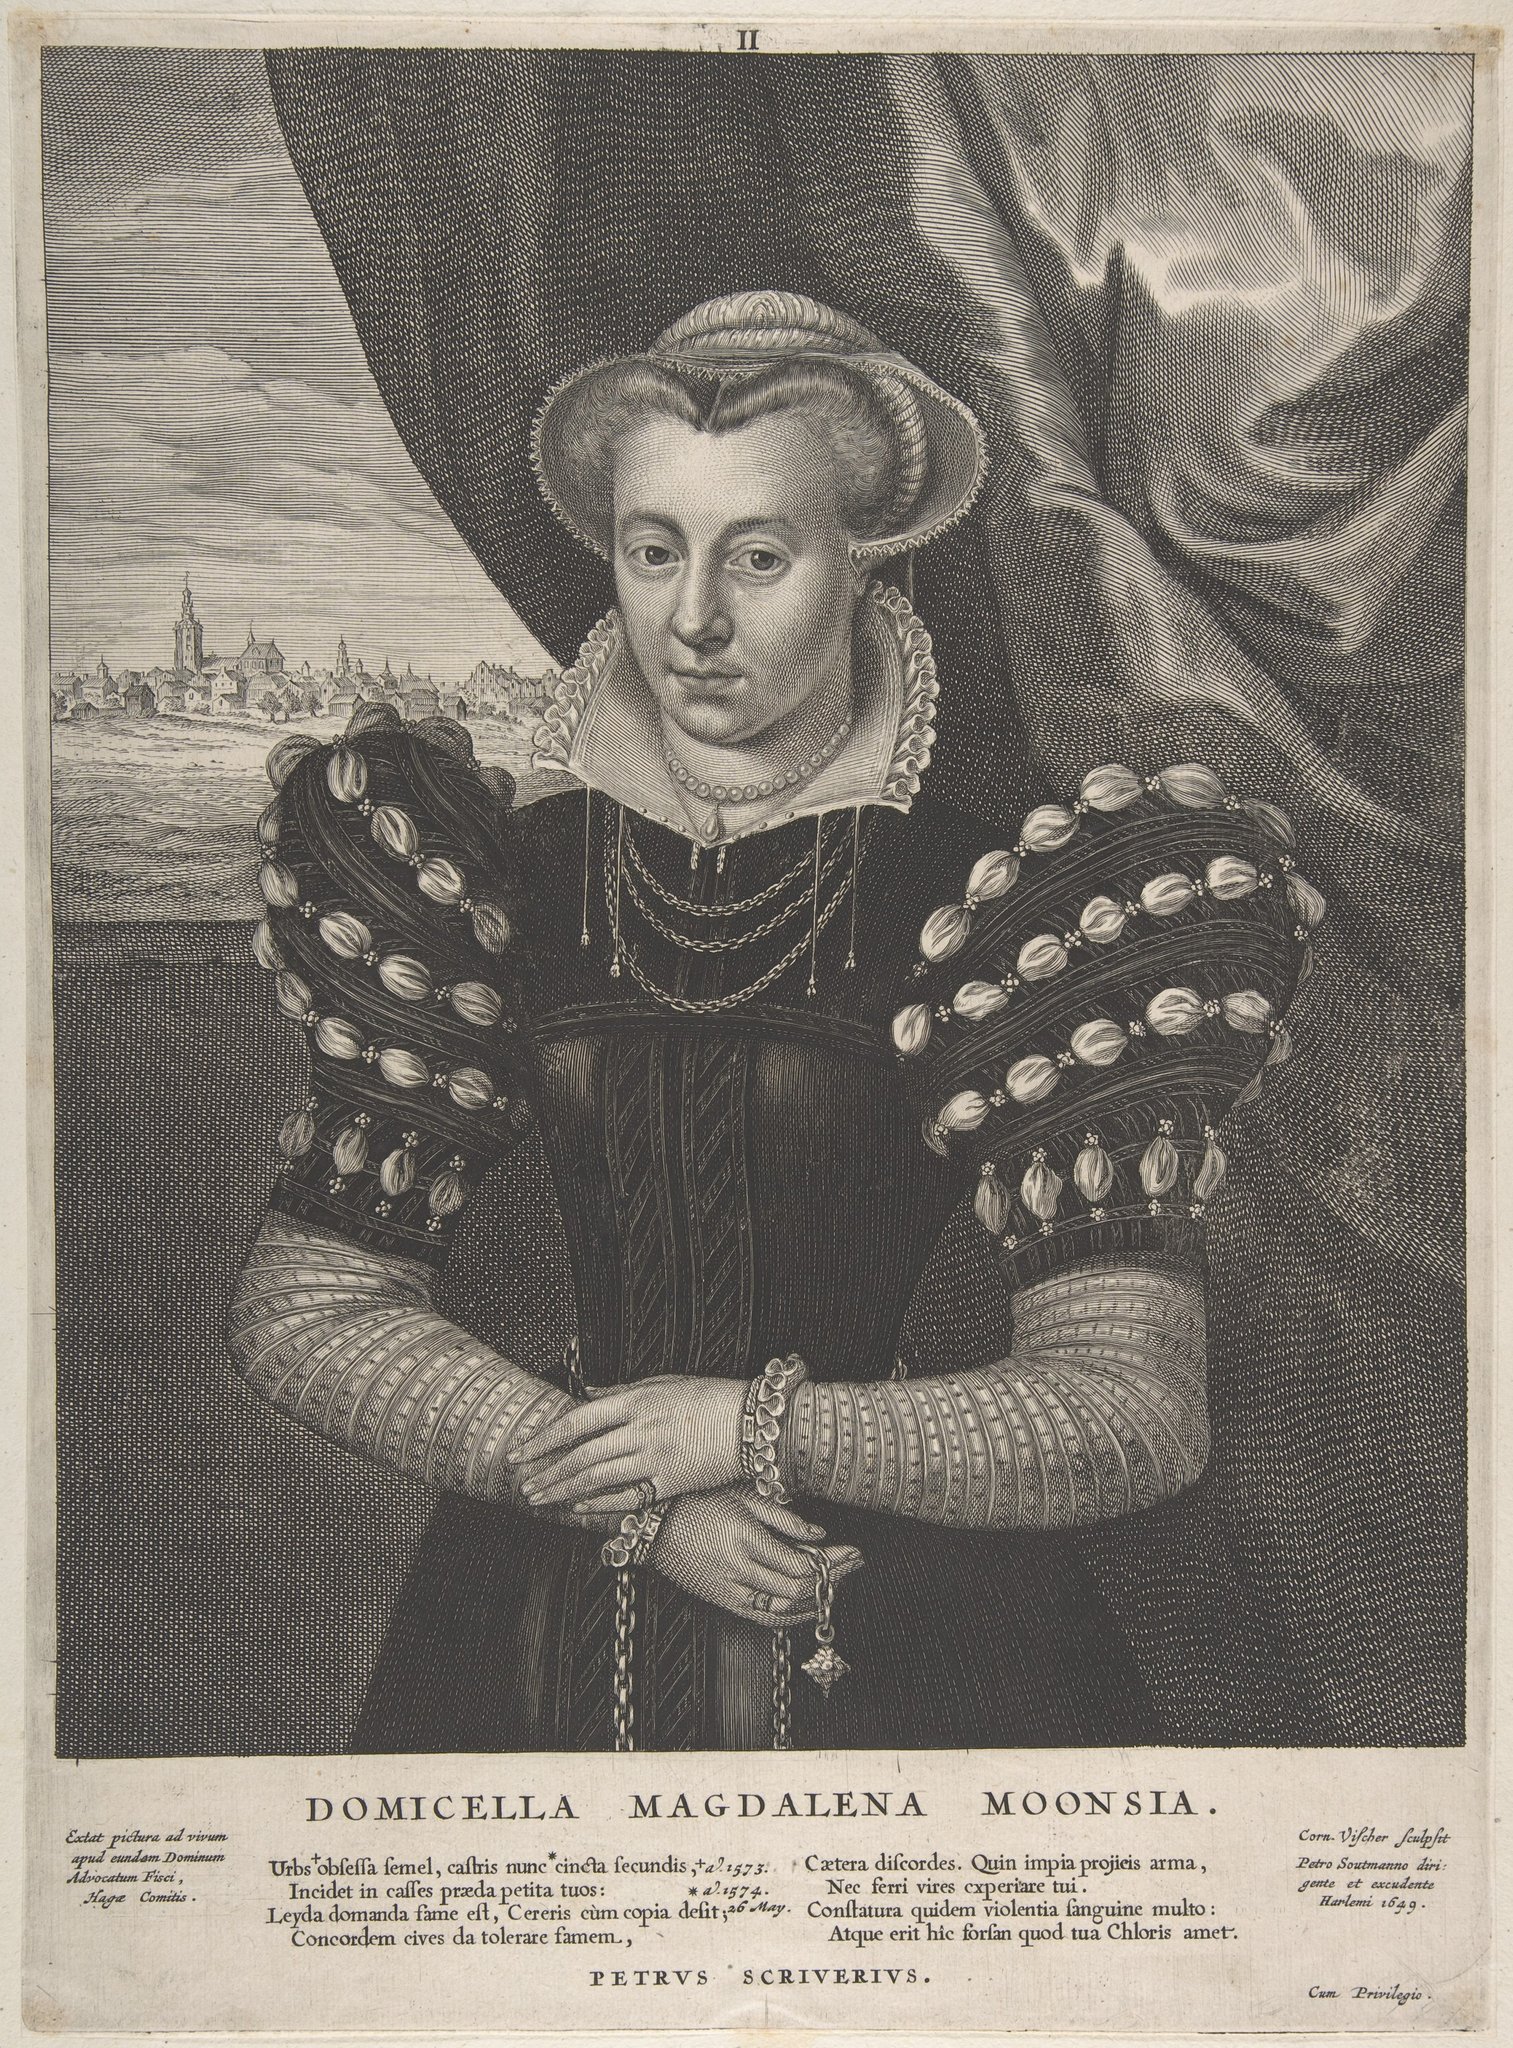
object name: print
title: Magdalena Moons, from the series Quatuor Personae...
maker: pieter soutman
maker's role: artist and publisher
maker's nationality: dutch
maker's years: 1580-1657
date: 1649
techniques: engraving, etching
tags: portraits,women